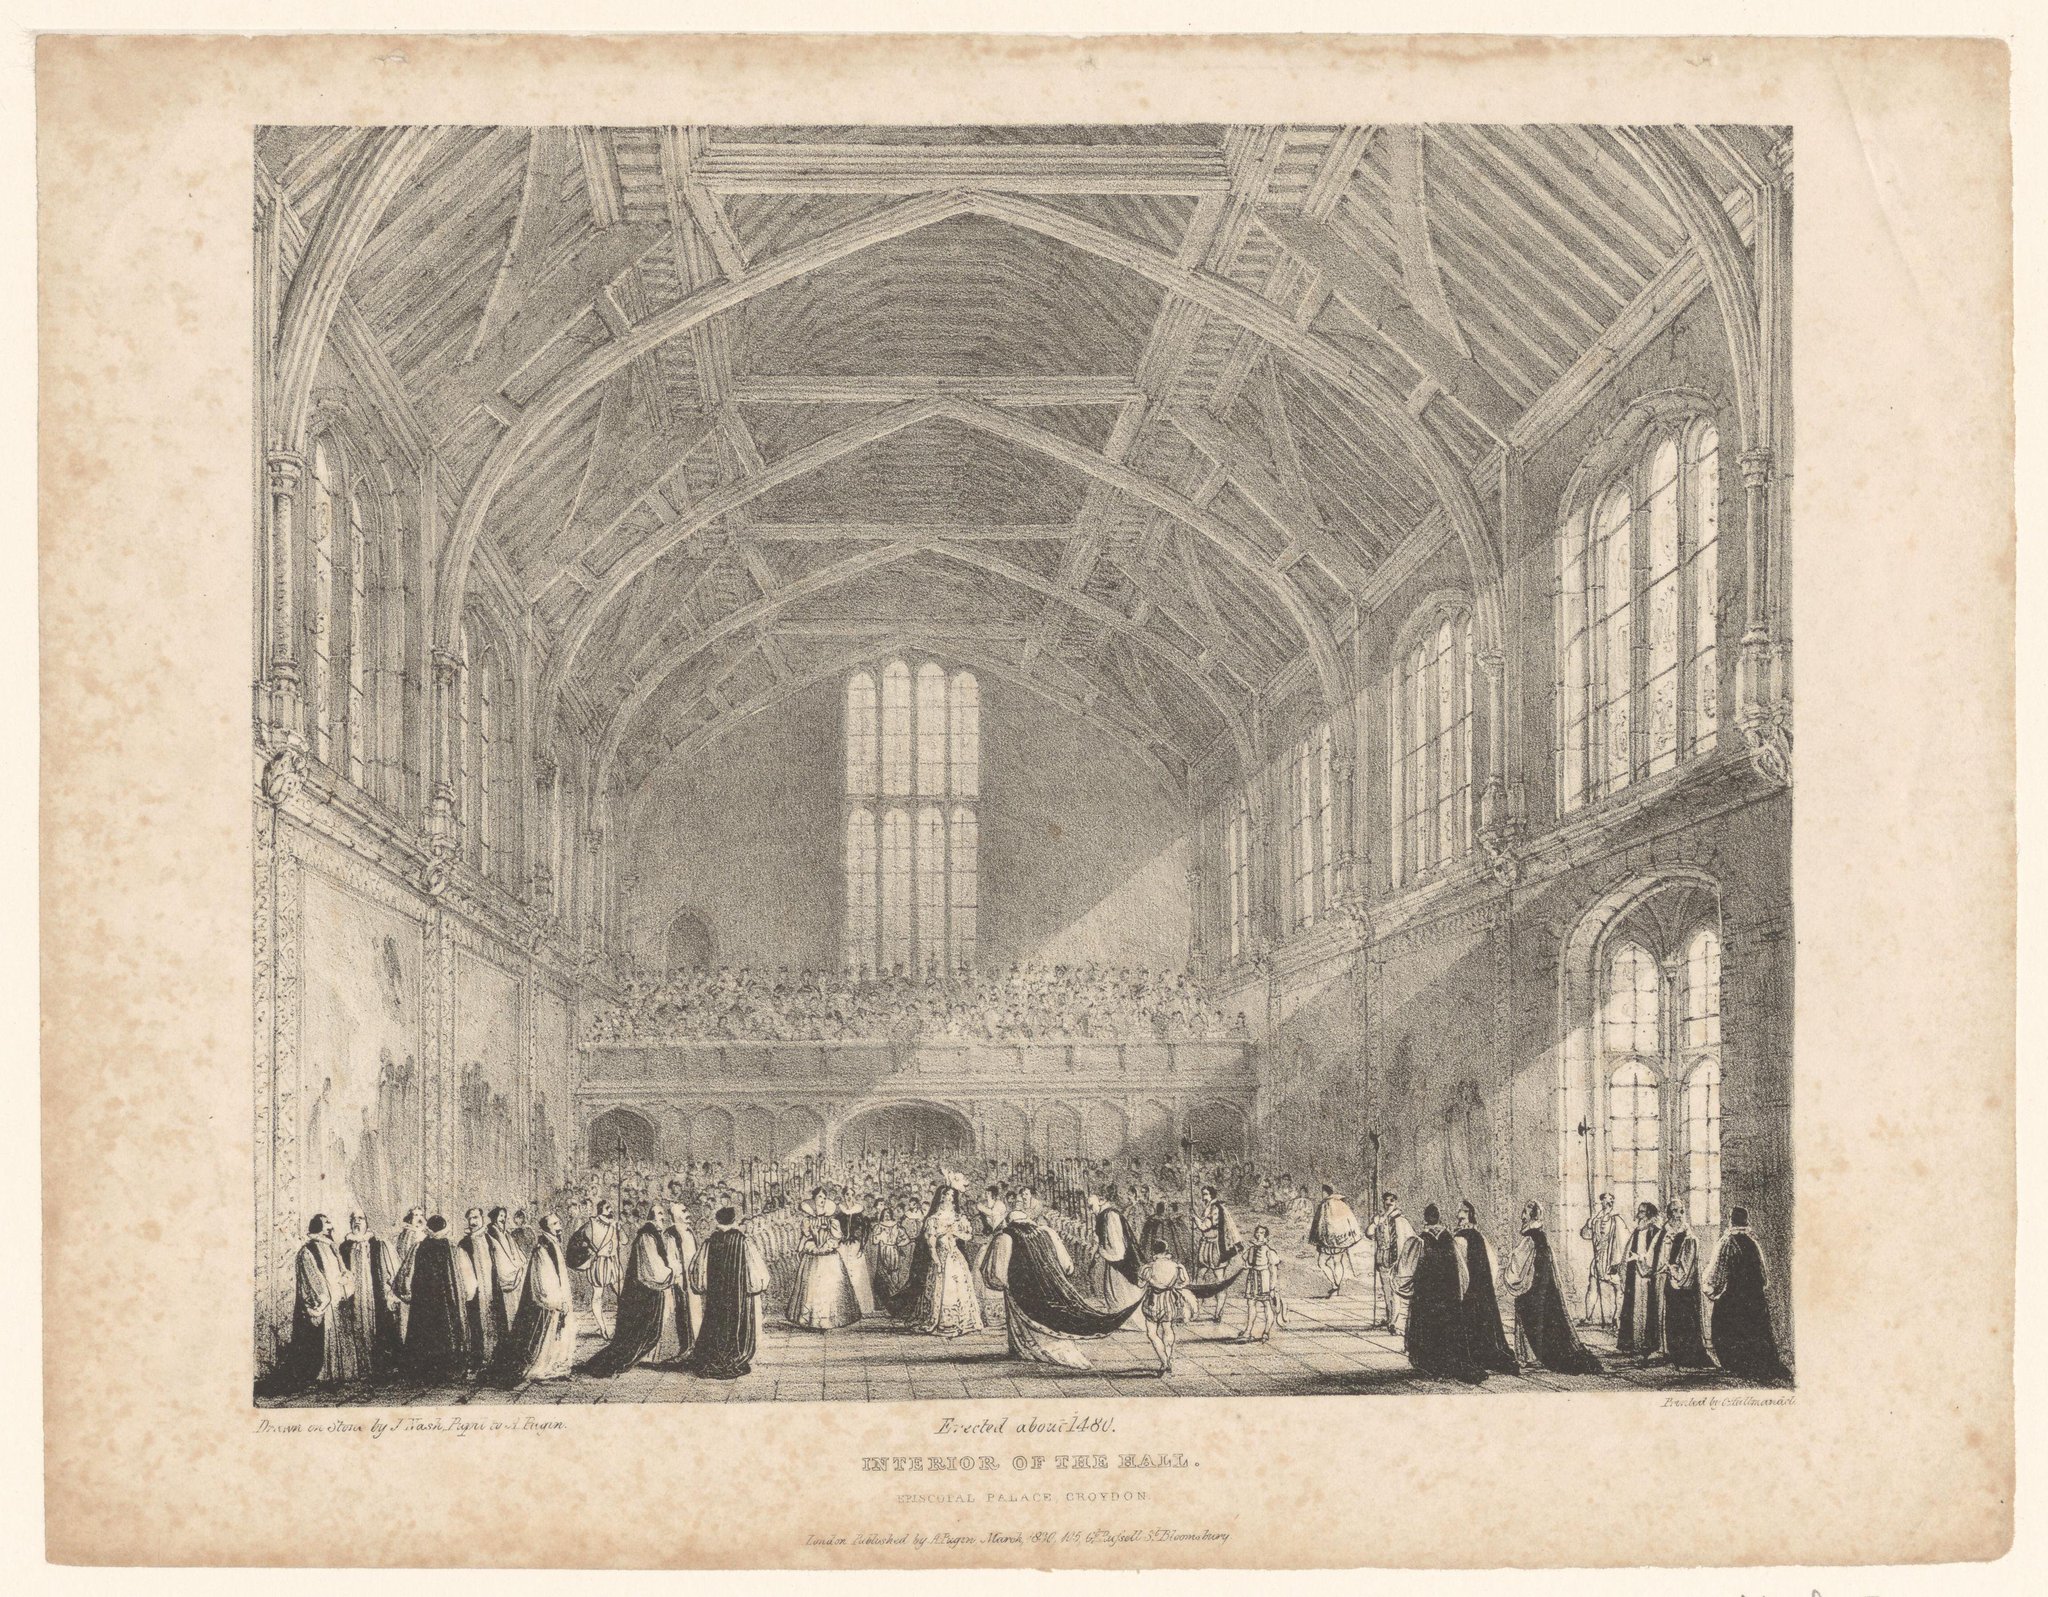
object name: print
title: Ceremonie in een zaal te Croydon Palace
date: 1830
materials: paper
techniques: lithograph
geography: london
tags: palace - aa - civic architecture: inside, festivities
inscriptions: collector's mark: Lugt 2228